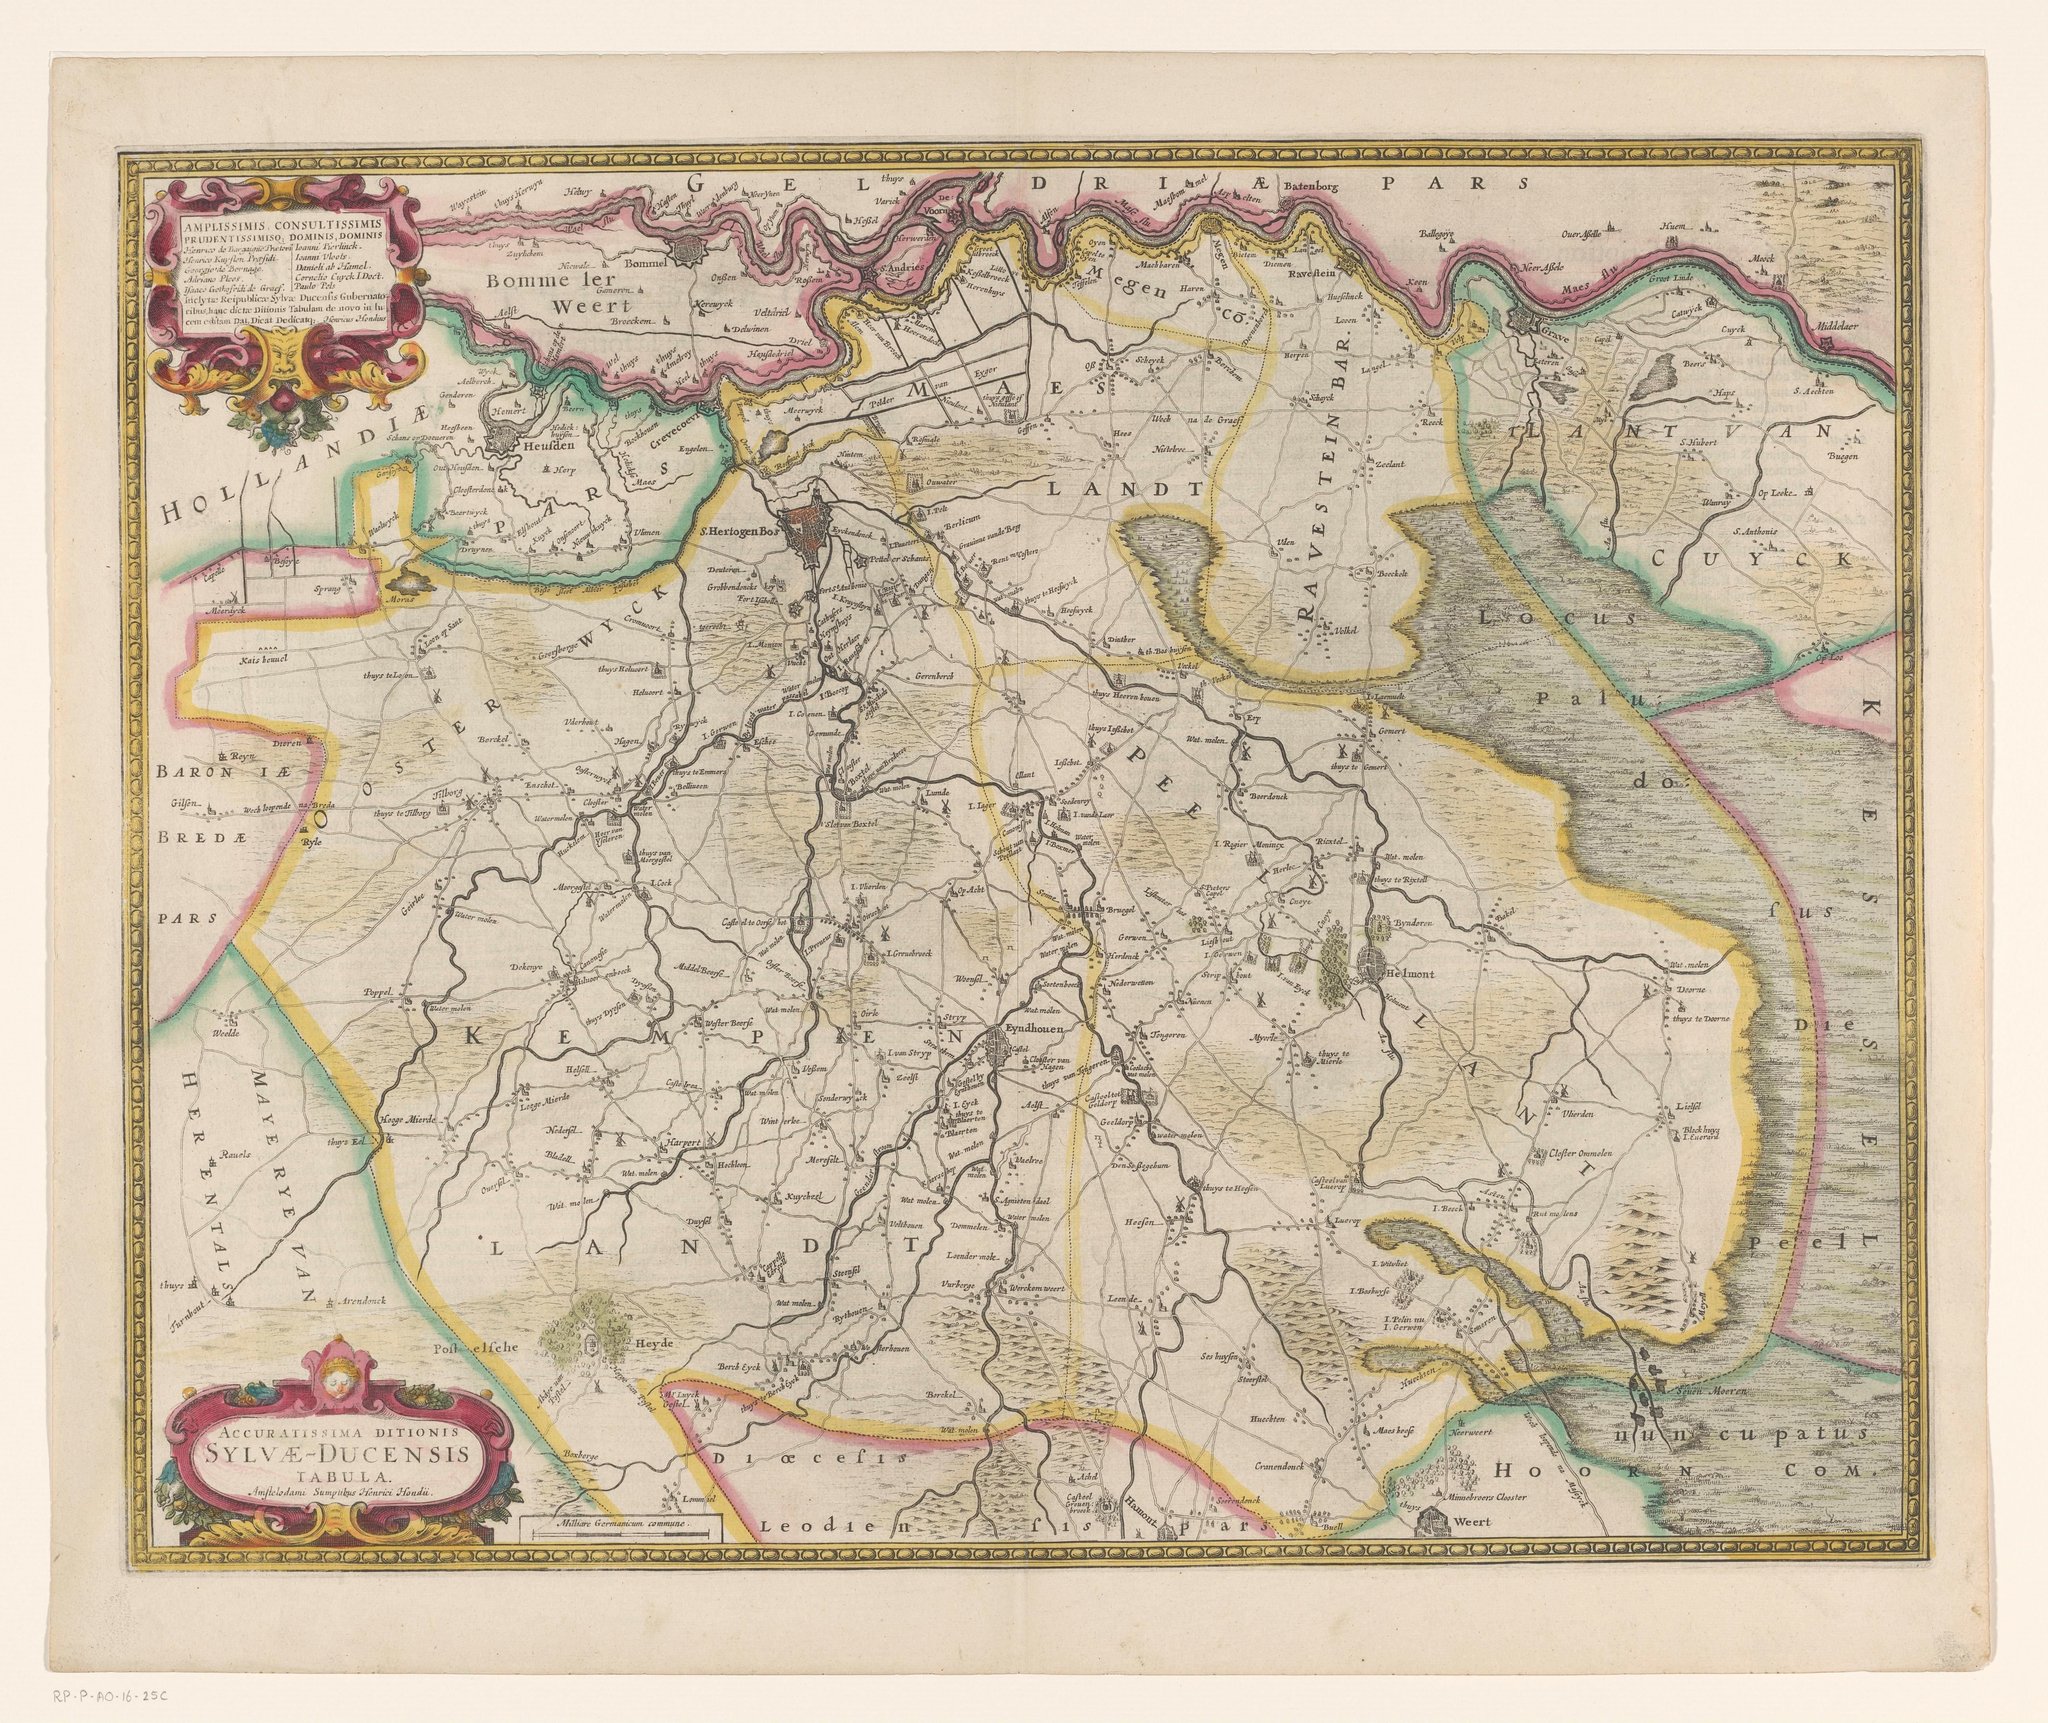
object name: print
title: Kaart van de Meierij van 's-Hertogenbosch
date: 1633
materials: paper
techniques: engraving, etching, hand coloring, letterpress printing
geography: den bosch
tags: maps of separate countries or regions, den bosch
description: Kaart van de Meierij van 's-Hertogenbosch. Linksboven een cartouche met de opdracht. Linksonder de titelcartouche. Rechts van de titelcartouche een schaalstok: Milliare Germanicum commune. Op verso Franse tekst.